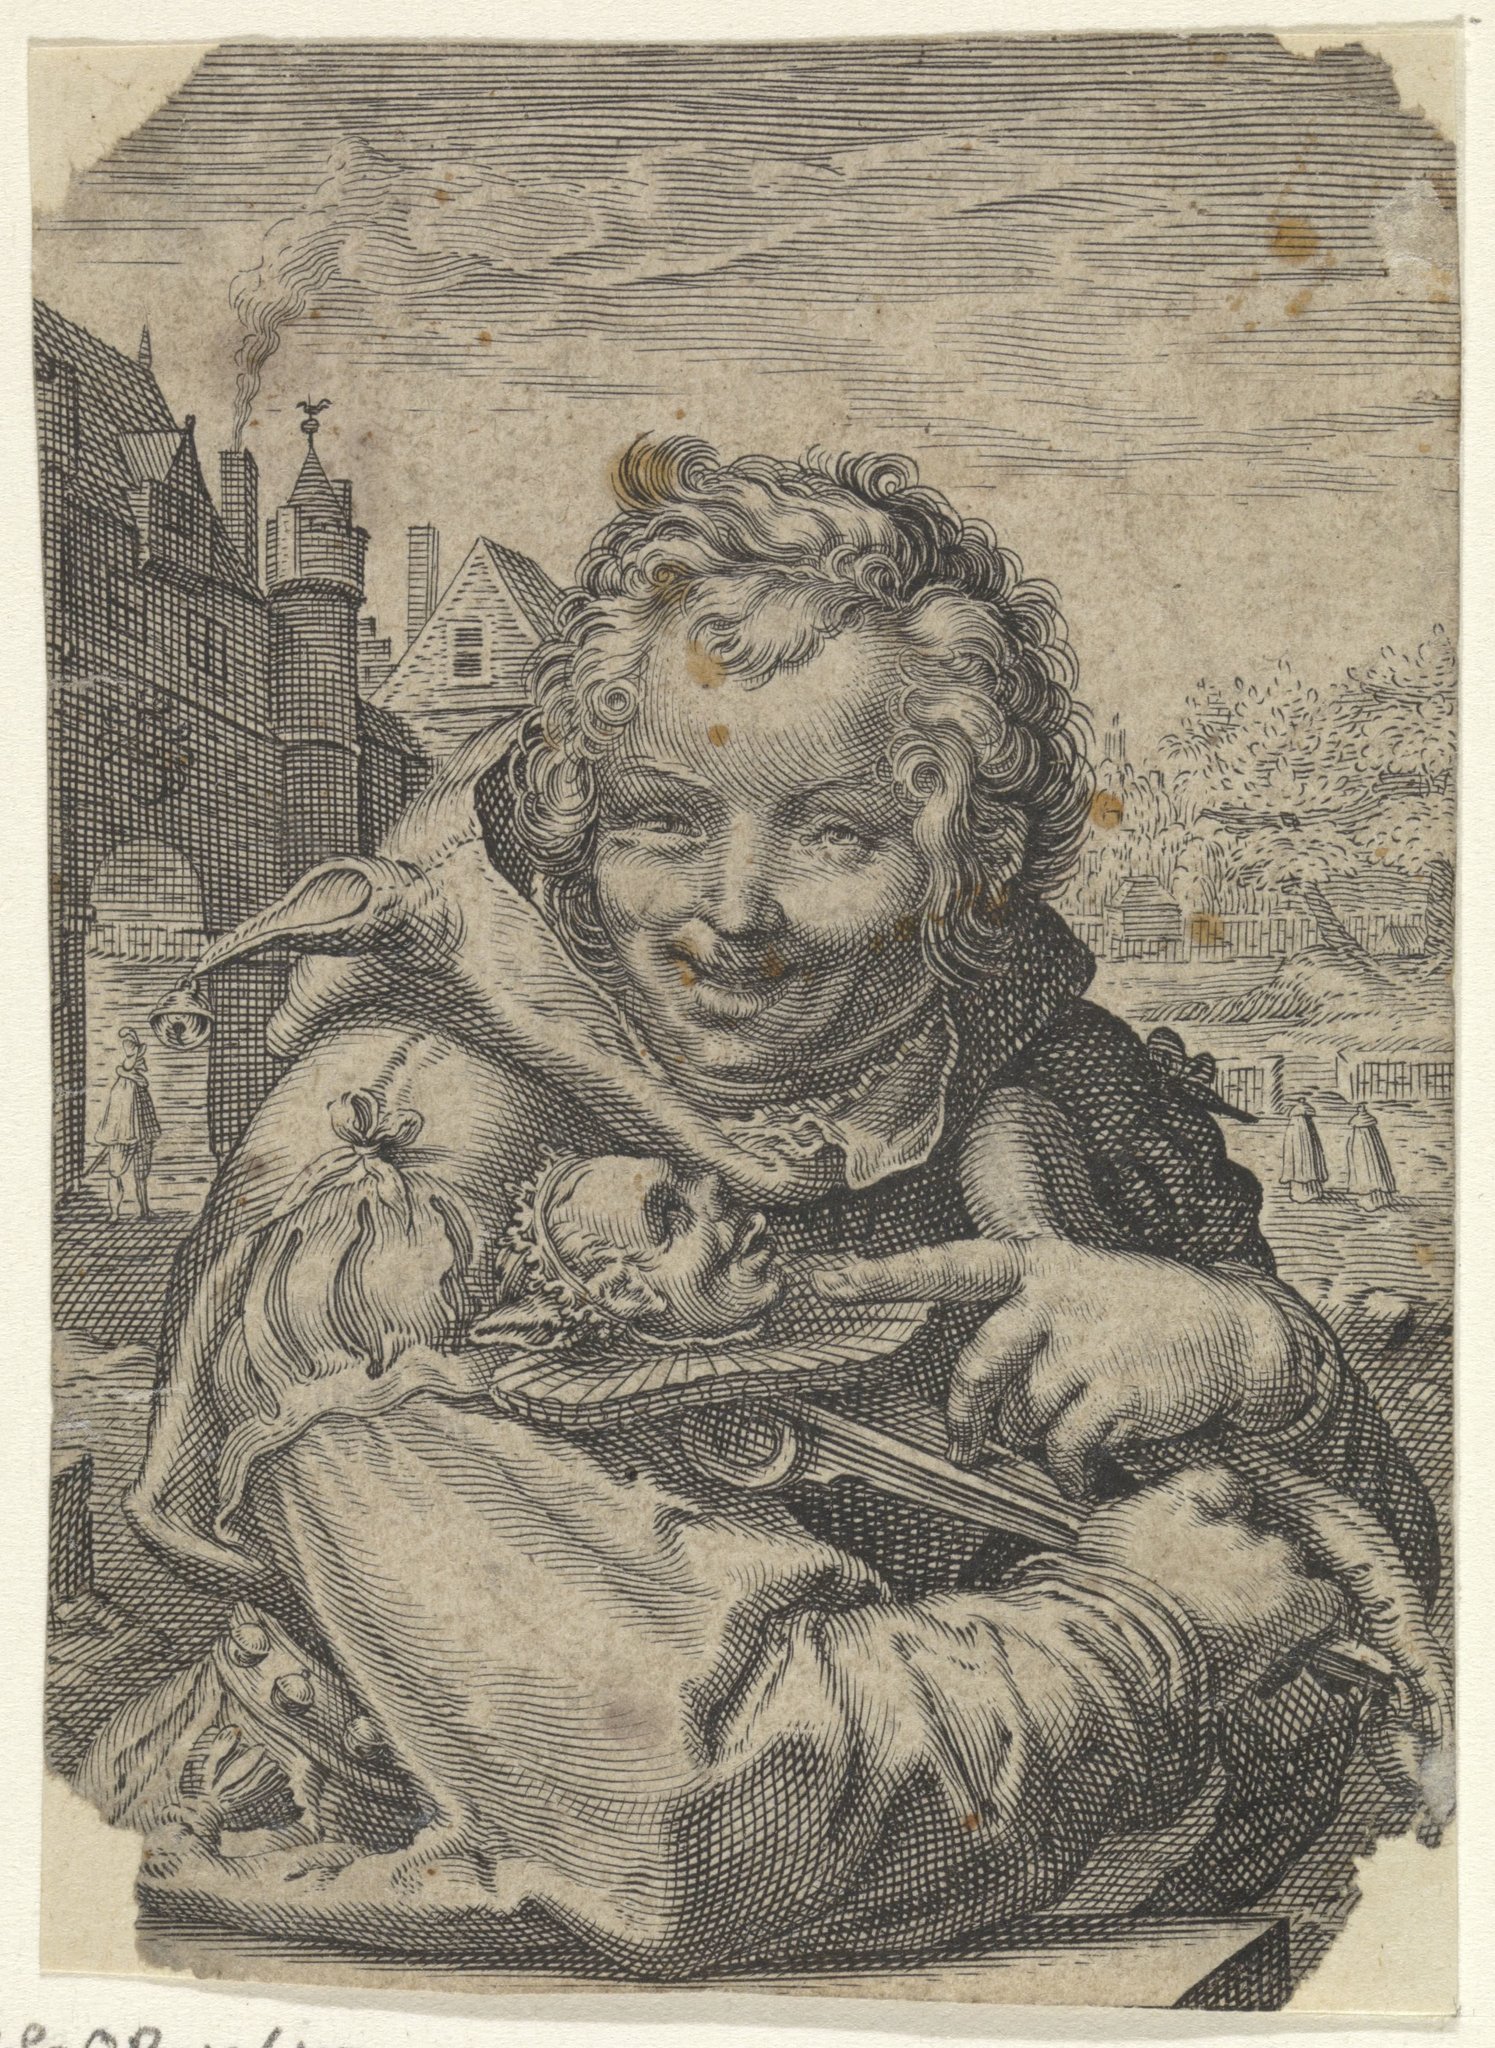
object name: print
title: Lachende nar met een staf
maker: Anonymous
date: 1590-1657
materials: paper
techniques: engraving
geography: northern netherlands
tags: court jester, court fool, laughing, gate, entrance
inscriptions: collector's mark: Lugt 2228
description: Een nar wijst lachend op zijn staf. De staf heeft een narrenhoofd dat zijn tong uitsteekt. Linksachter een poortgebouw en rechtsachter lopen twee in mantels gehulde figuren, monniken(?).